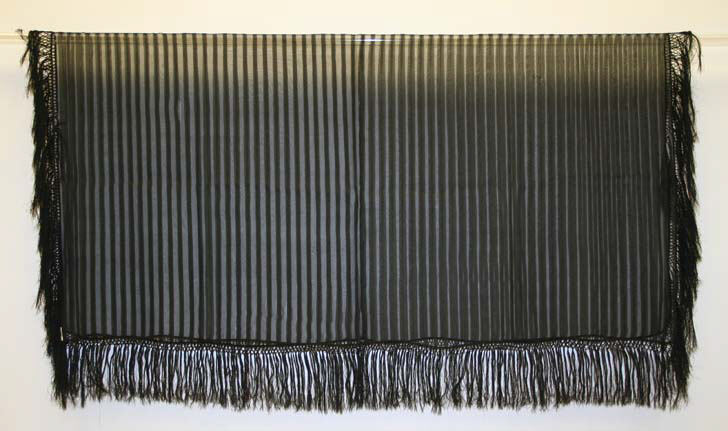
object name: shawl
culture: french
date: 1840-1849